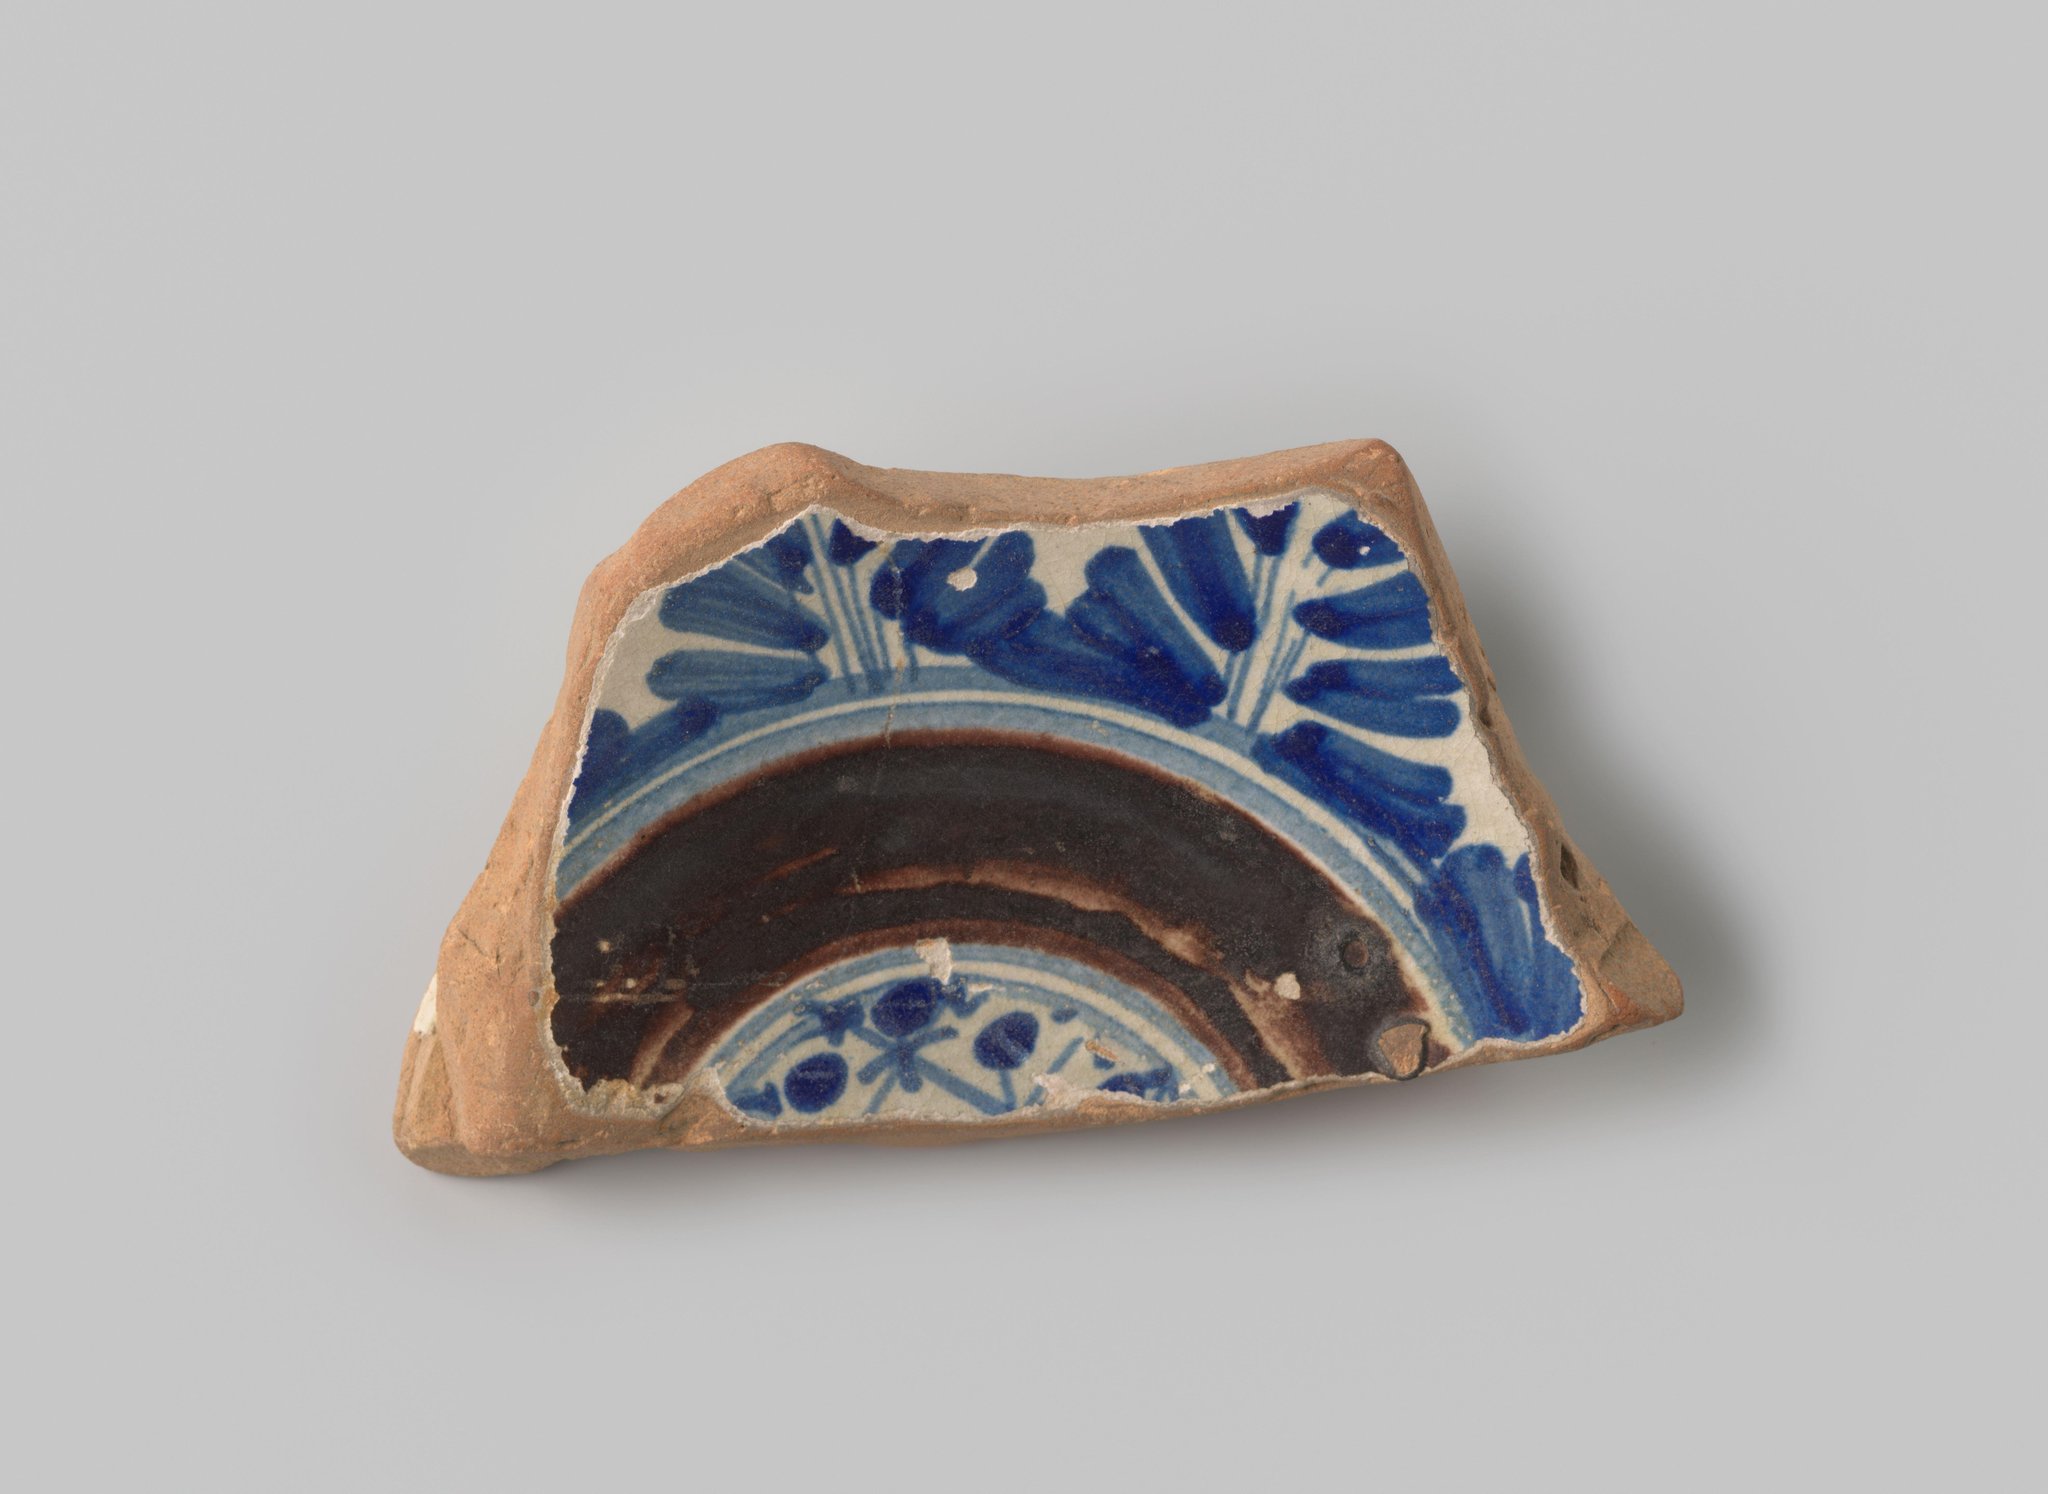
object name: sherd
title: Fragment van een schotel met roodbakkende scherf, met aan de voor- en achterzijde wit glazuur, waarop aan de voorzijde met blauw en purper glazuur een halve cirkel bladvormen, een halve cirkel en een ruitpatroon zijn geschilderd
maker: Anonymous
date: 1200-1899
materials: earthenware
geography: italy